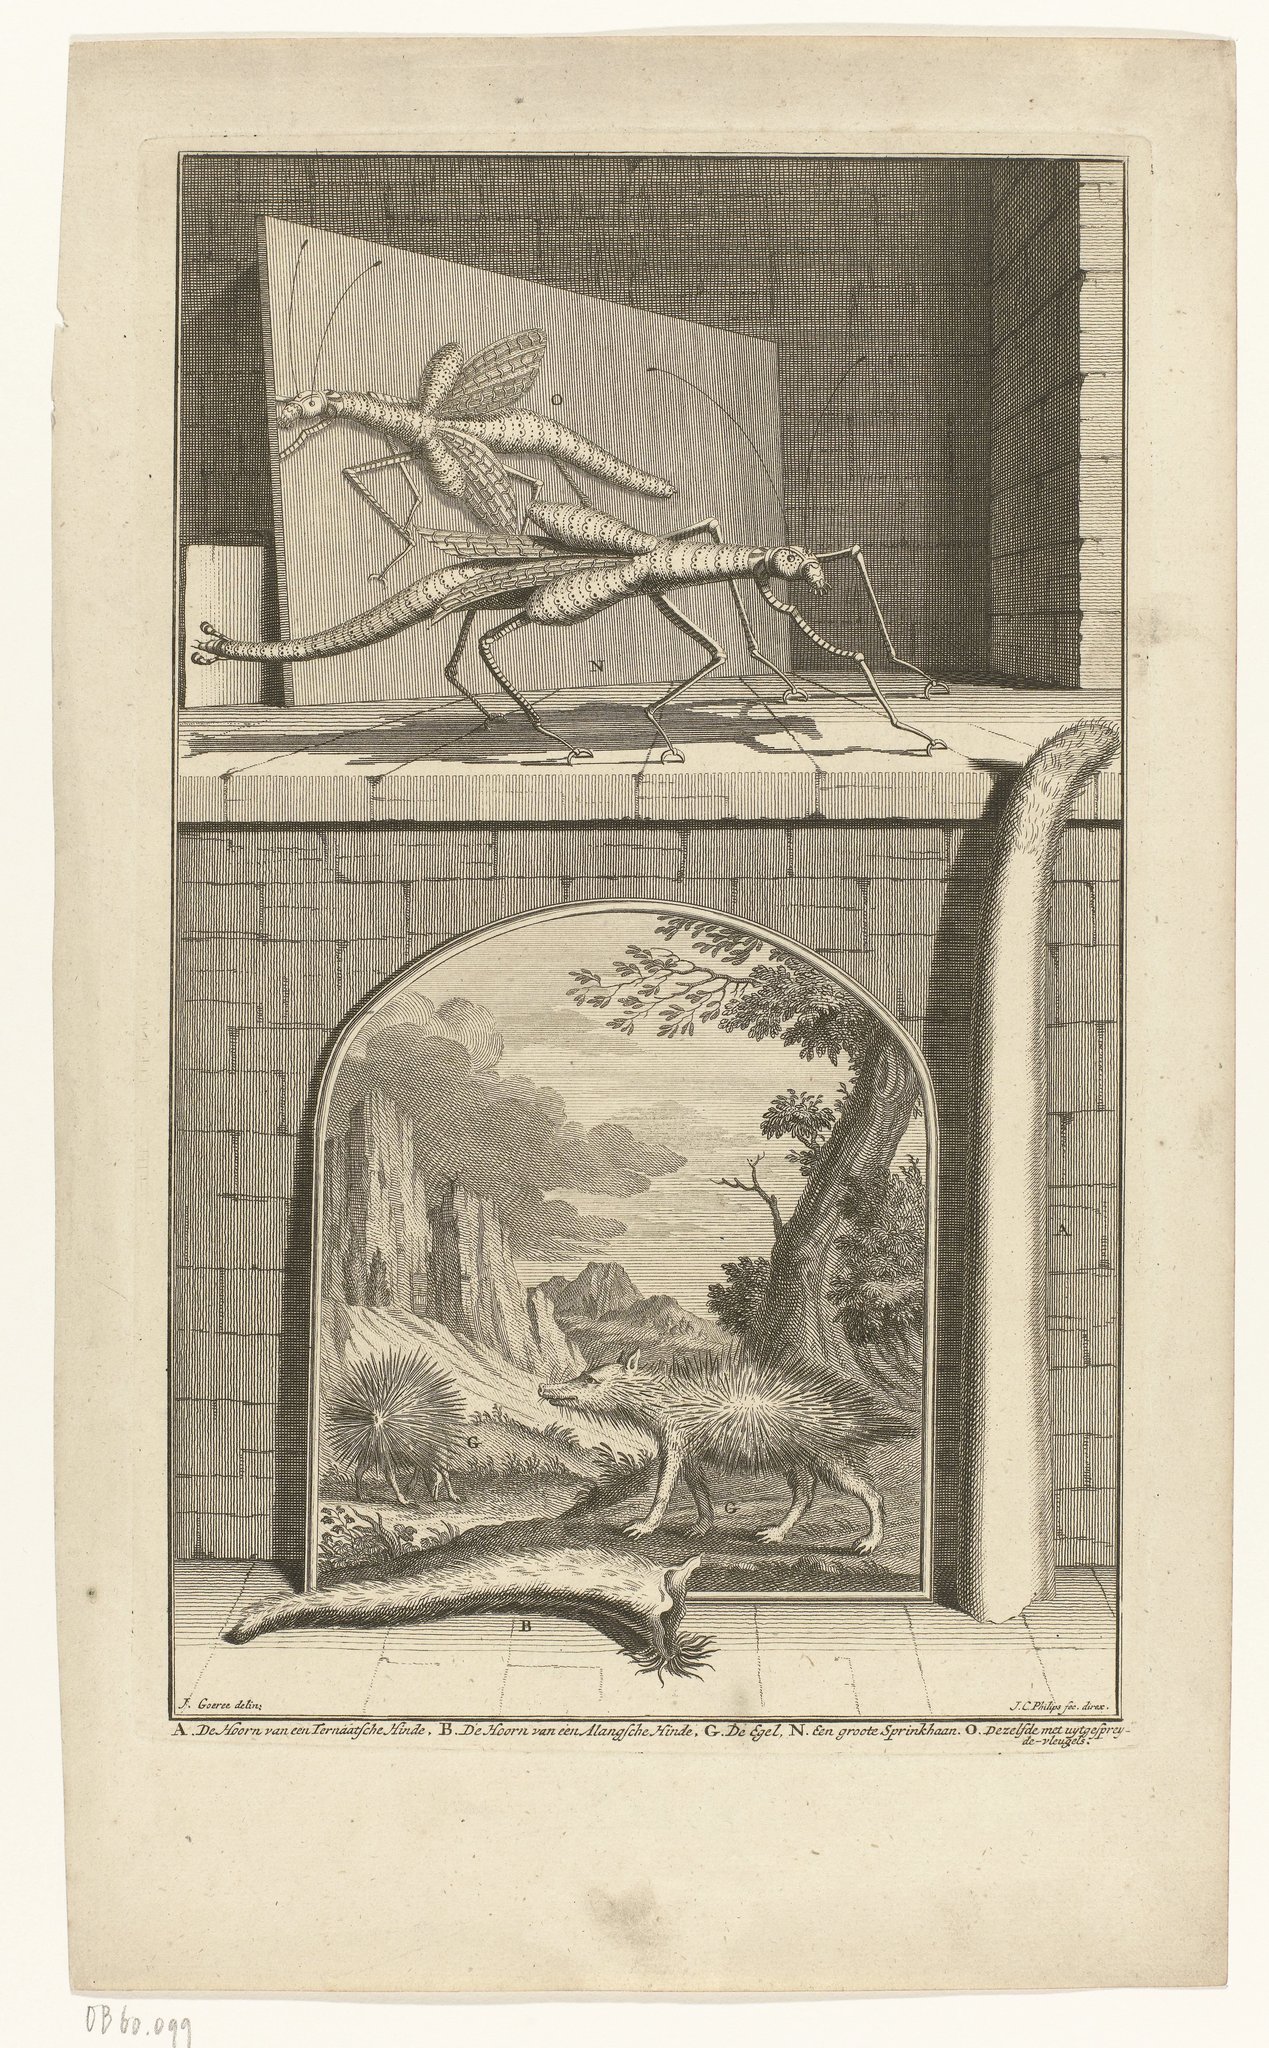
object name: book illustration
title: Blad met hoorns, egels en insecten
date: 1736-1775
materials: paper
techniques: engraving, etching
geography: amsterdam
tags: animals (+ antlers; horn), other mammals: hedgehog, insects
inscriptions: collector's mark: Lugt 2228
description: Blad met hoorns, egels en insecten. Bij elk een letter die naar de legenda verwijst.